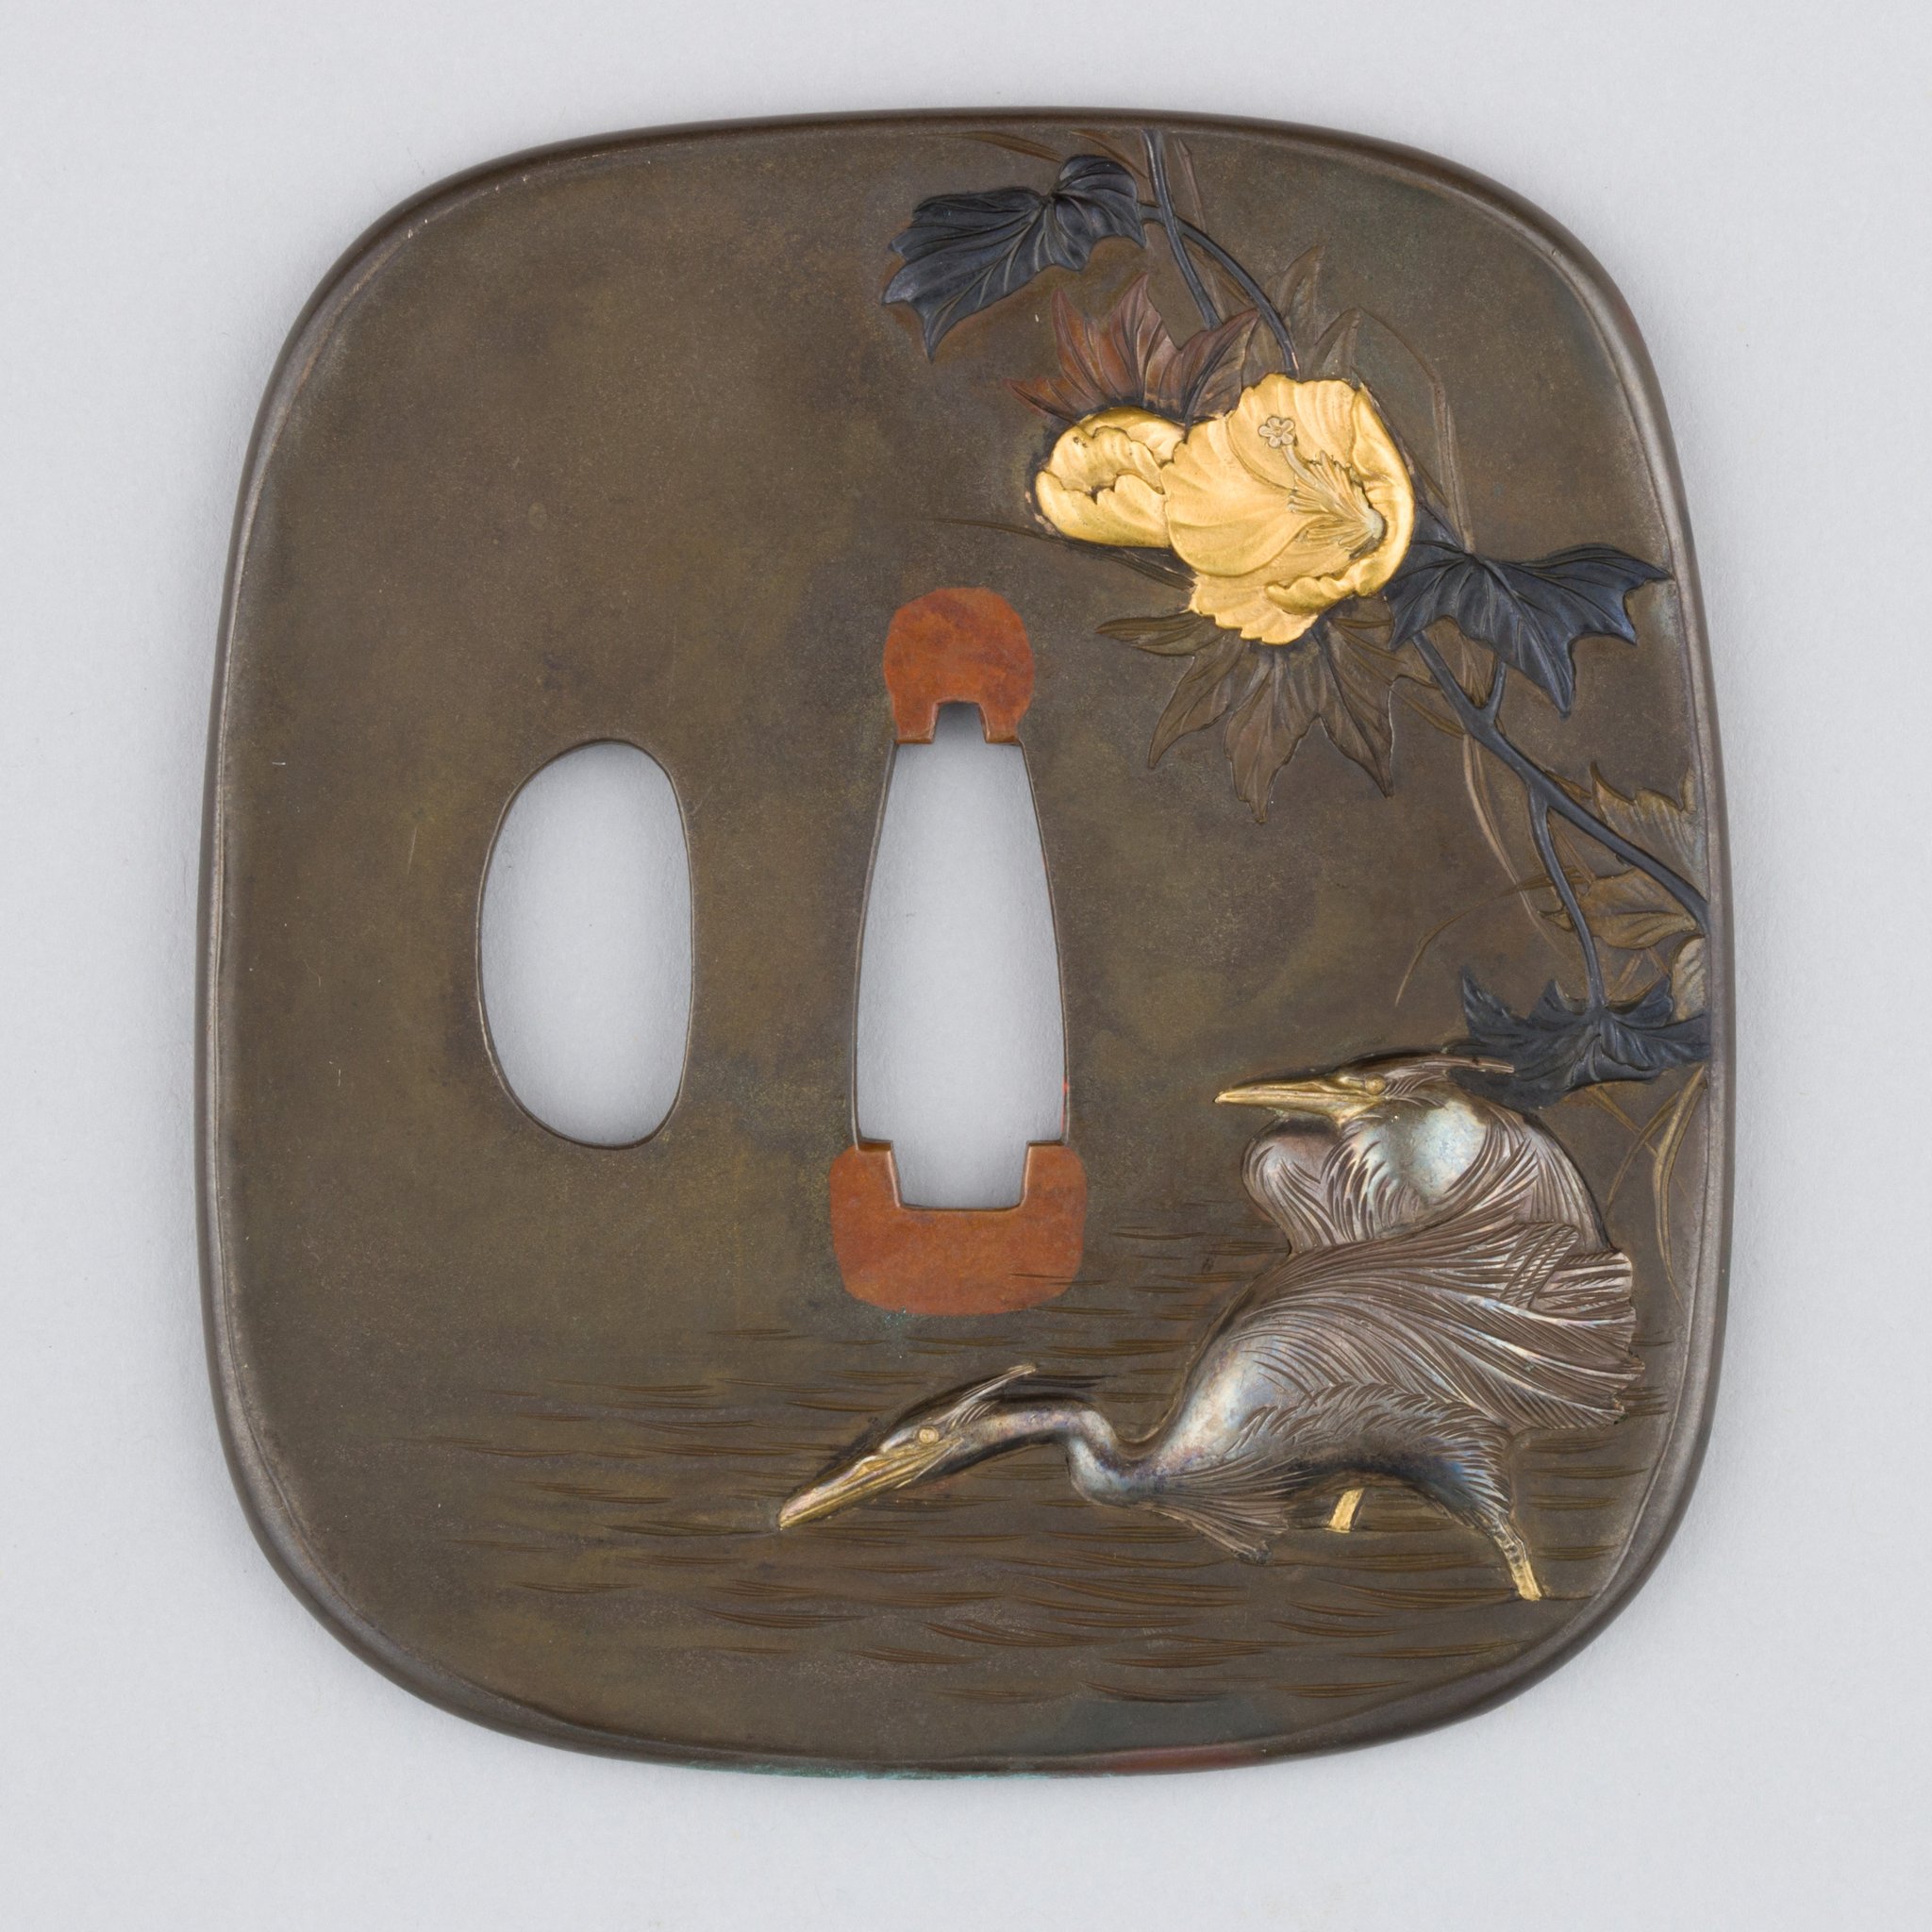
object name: sword guard tsuba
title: Sword Guard (Tsuba)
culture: japanese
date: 1615-1868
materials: copper, copper alloy, gold alloy, silver alloy, gold, silver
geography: japan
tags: birds,flowers